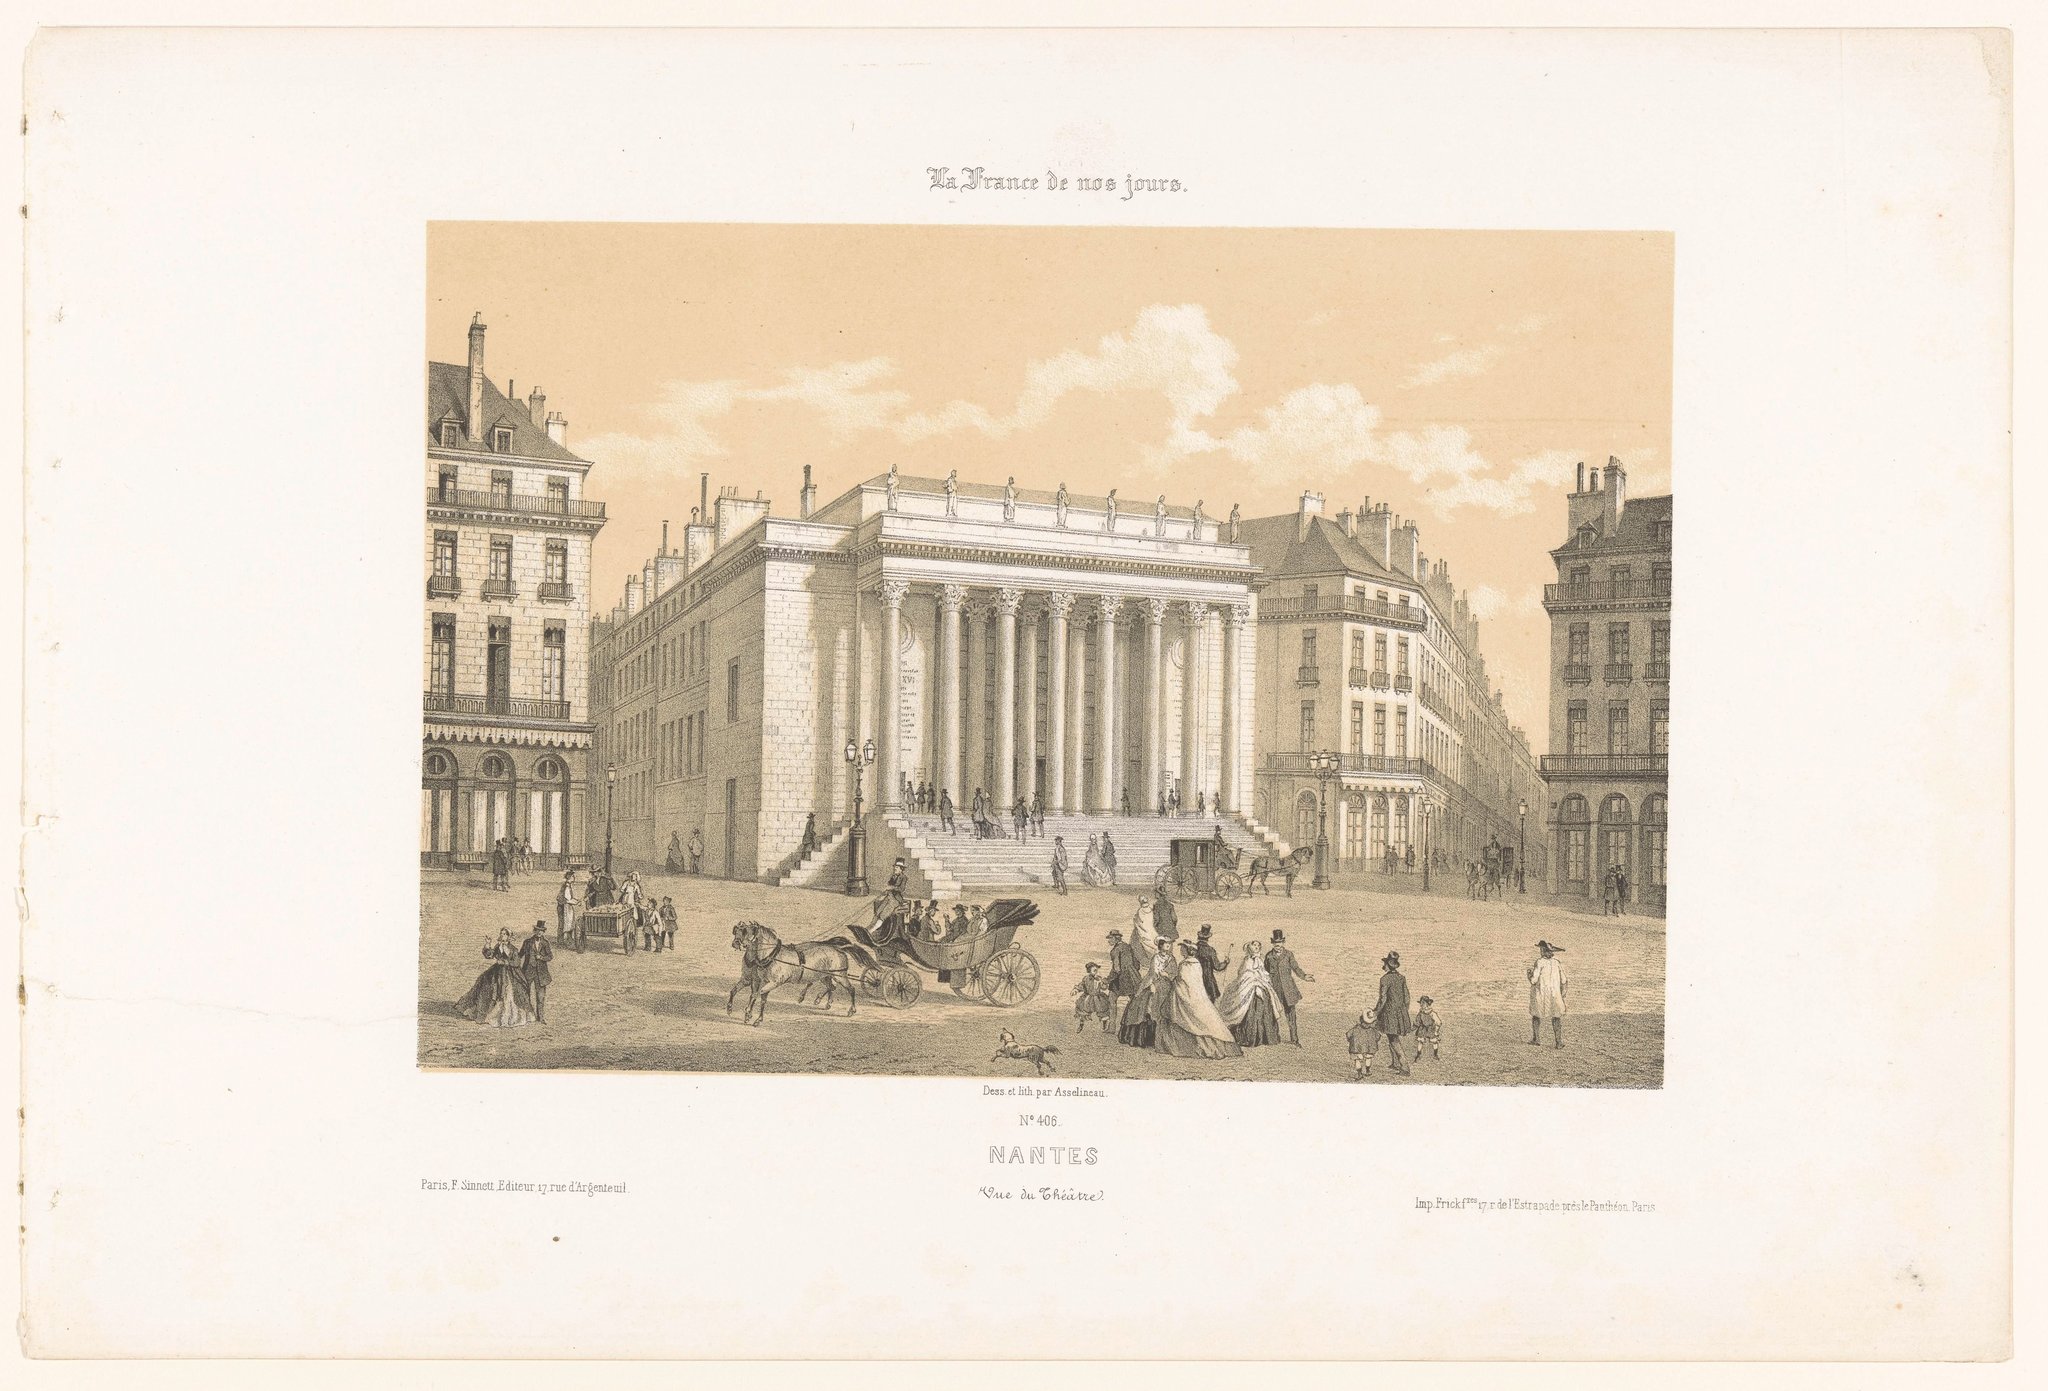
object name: print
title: Hedendaags Frankrijk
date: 1863-1864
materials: paper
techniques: tone lithography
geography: paris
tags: theatre (building), village square, place, opera house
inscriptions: collector's mark: Lugt 2228